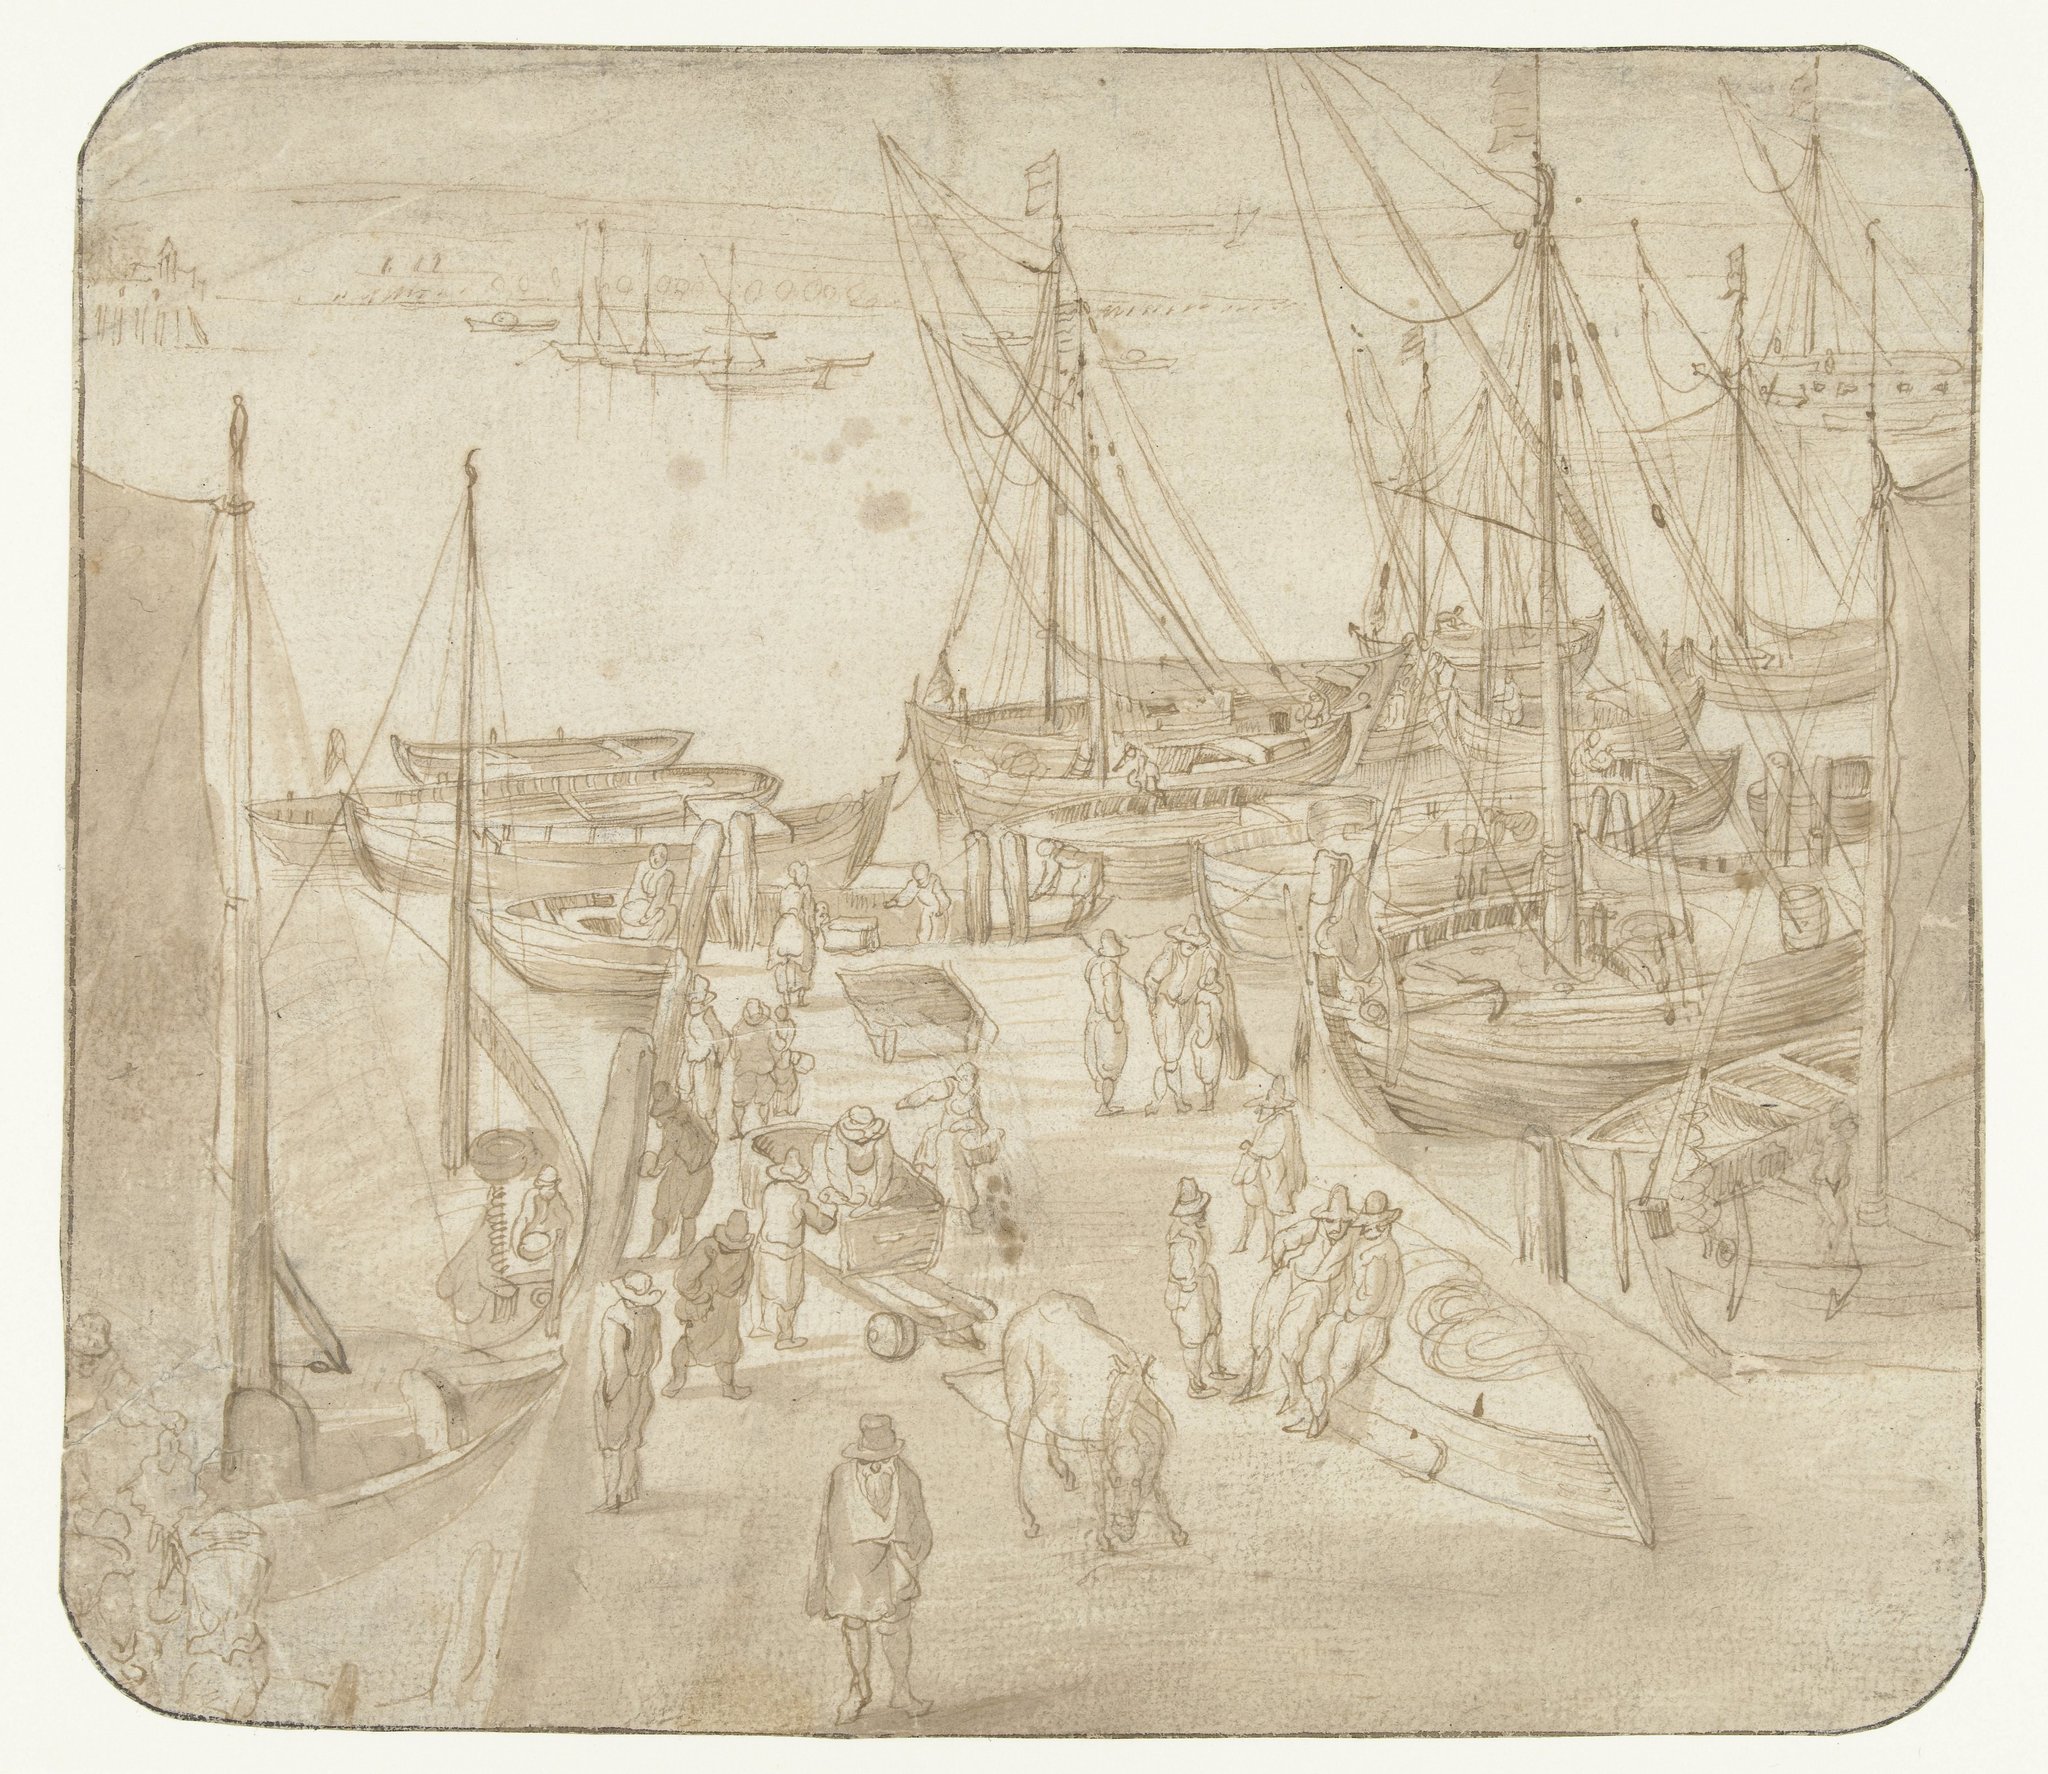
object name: drawing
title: Schepen bij een havenhoofd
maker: Anonymous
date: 1600-1700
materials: chalk, ink, paper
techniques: brush, pen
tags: harbour, sailing-ship, sailing-boat